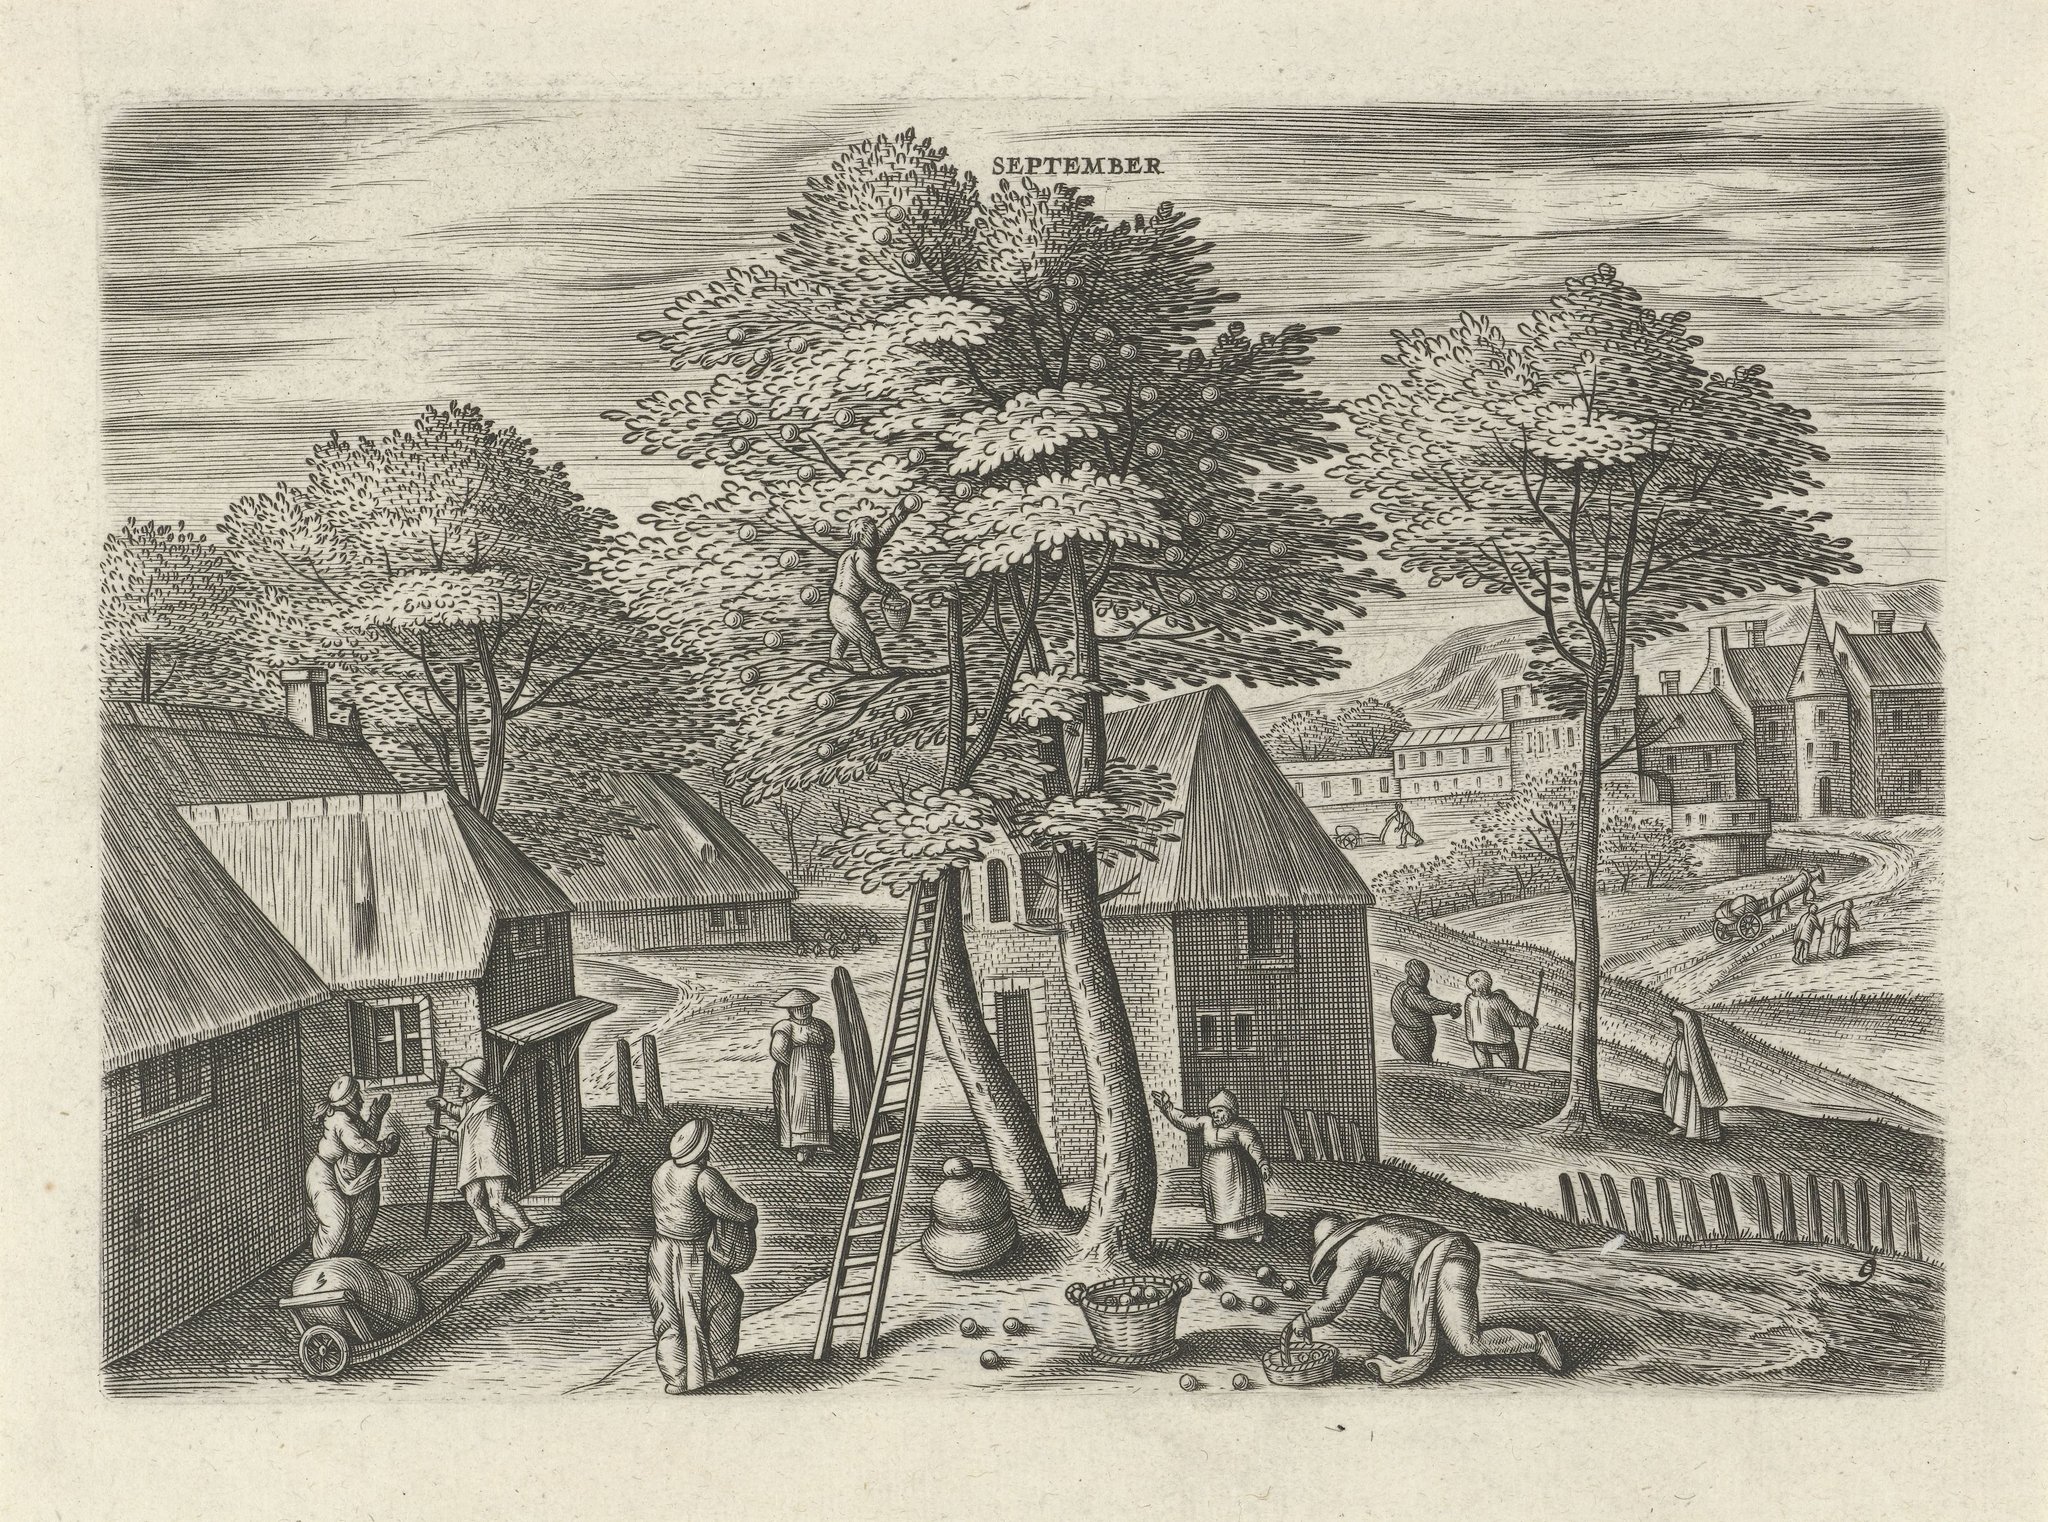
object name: print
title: De twaalf maanden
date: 1596-1652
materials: paper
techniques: engraving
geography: antwerp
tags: september and its 'labours', picking fruit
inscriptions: collector's mark: Lugt 2228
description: Herfstlandschap met najaartaferelen. September is de fruitmaand.In het midden de fruitoogst met mannen, vrouwen en kinderen die de appels plukken in een boomgaard. Deel van een serie van de twaalf maanden, waarbij elke maand wordt afgebeeld met de voor haar typerende menselijke activiteiten en haar klimatologische kenmerken.